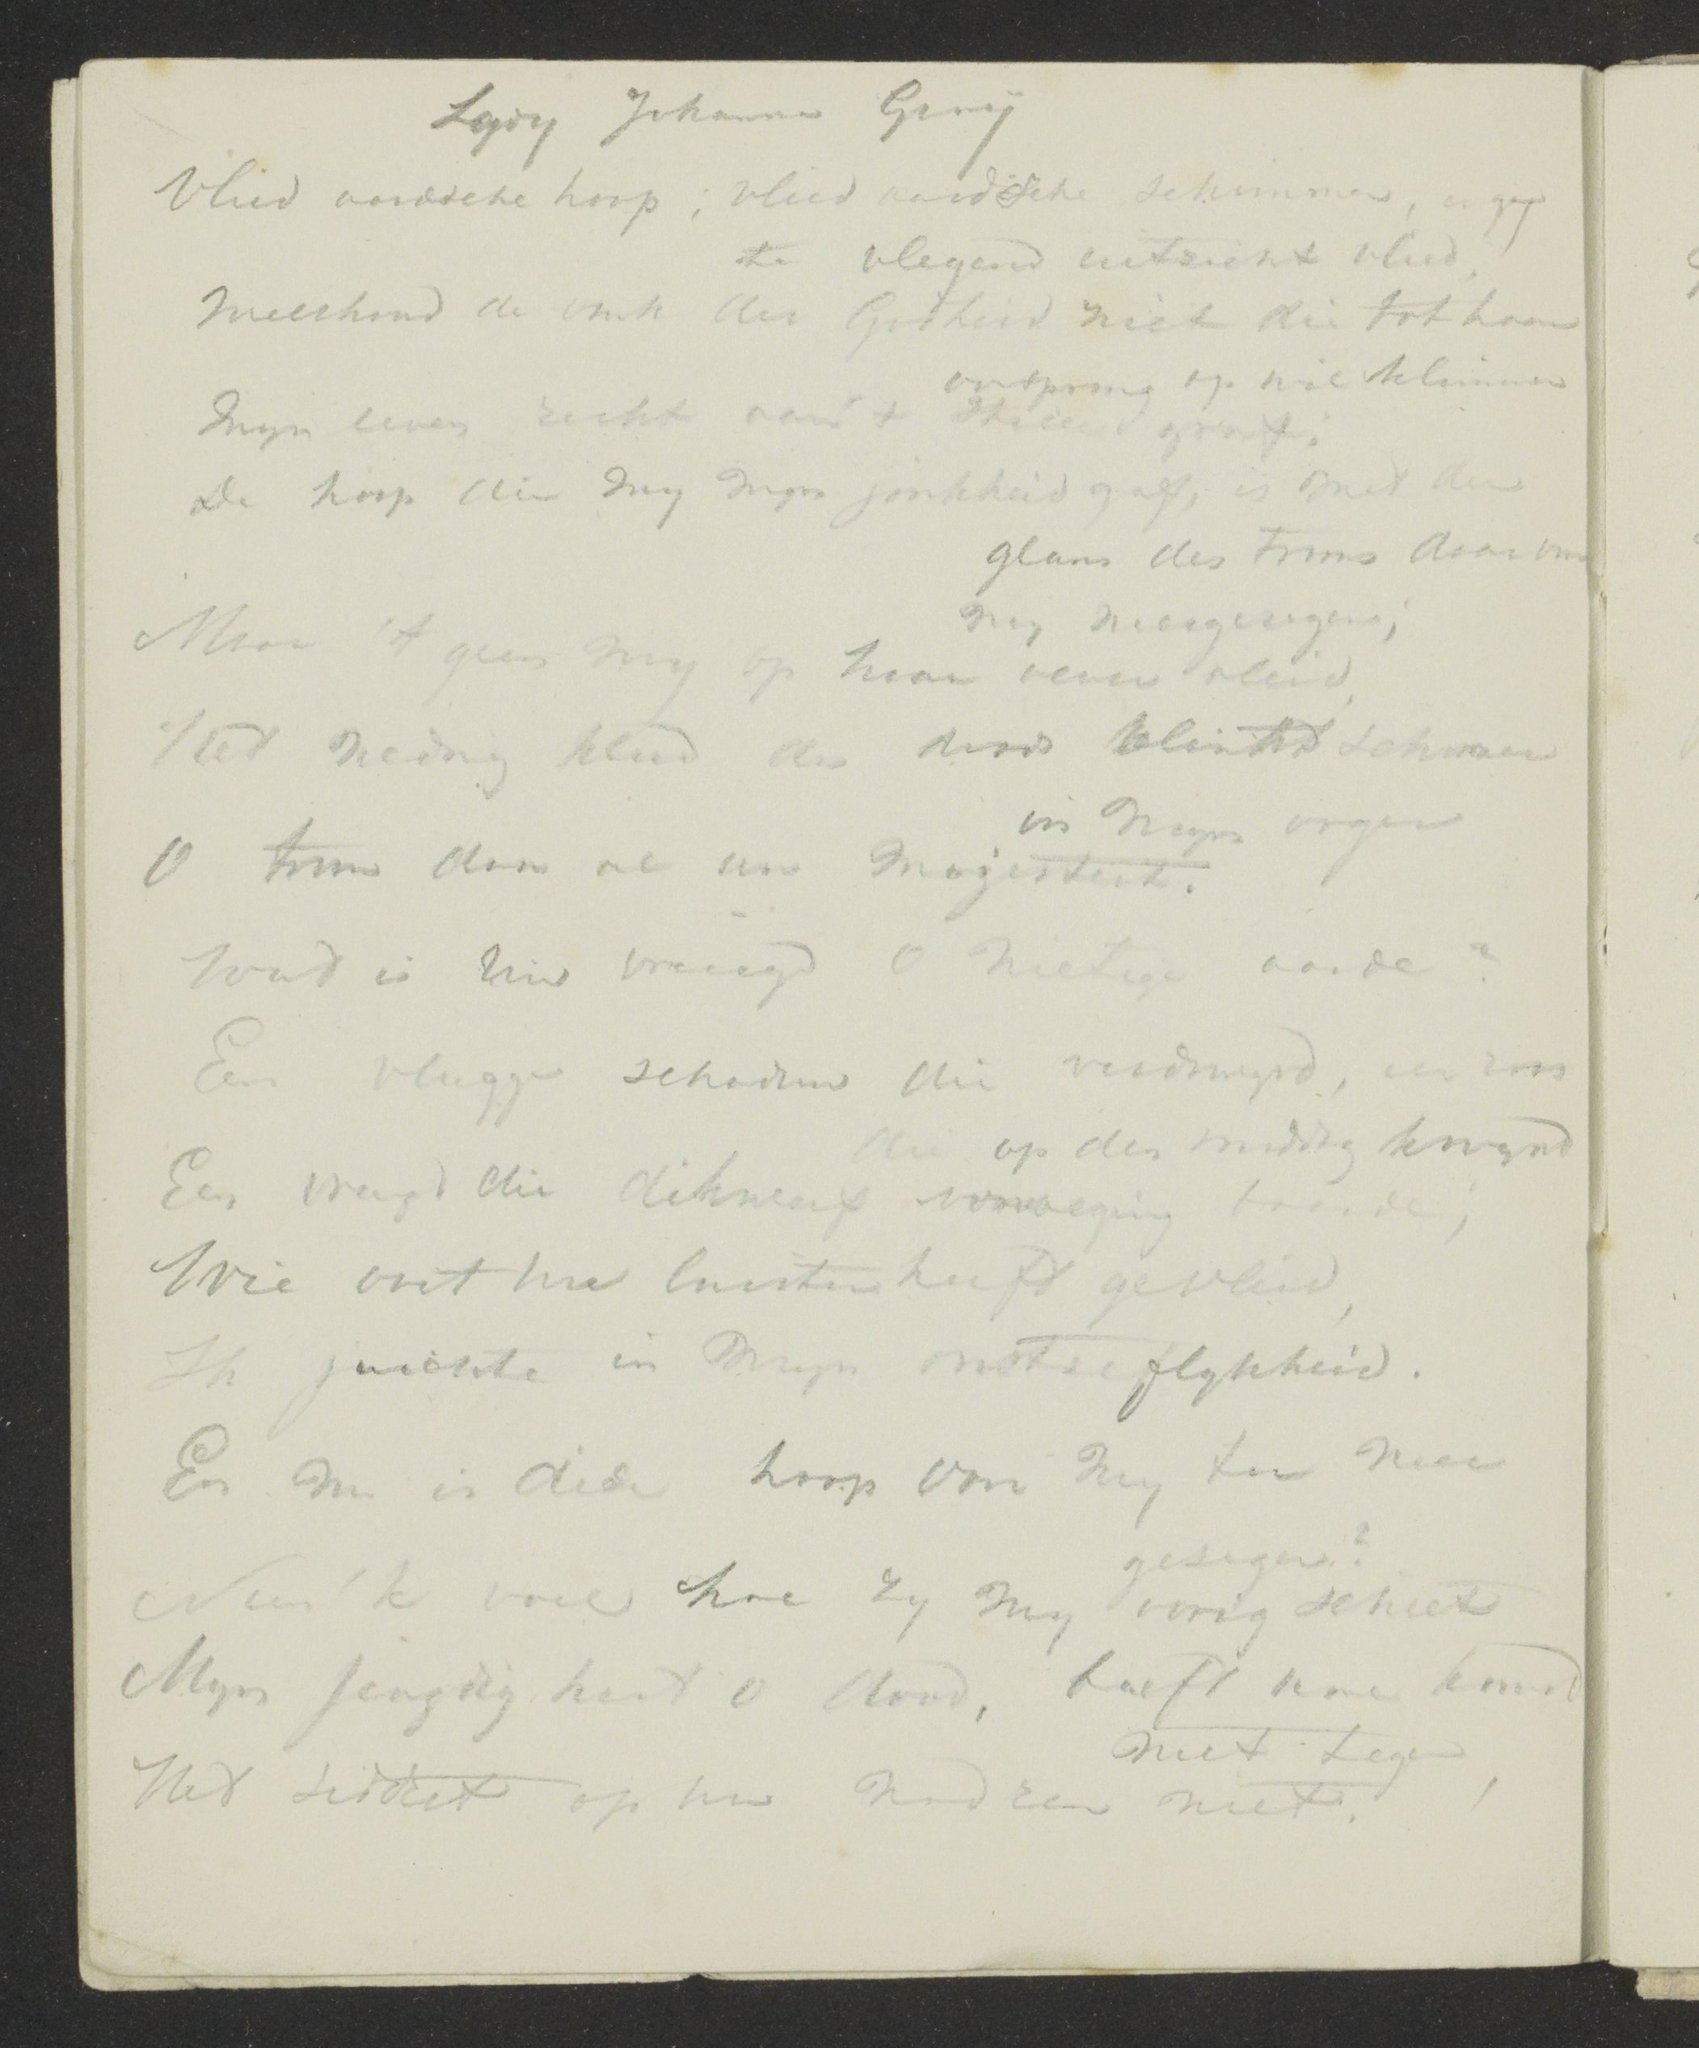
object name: sketchbook leaf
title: Gedicht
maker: maria vos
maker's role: draughtsman, painter, print maker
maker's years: 1824-1906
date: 1834-1906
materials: paper, pencil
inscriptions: annotation: ‘[...]’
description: Blad 2 verso uit een schetsboek met 17 bladen.